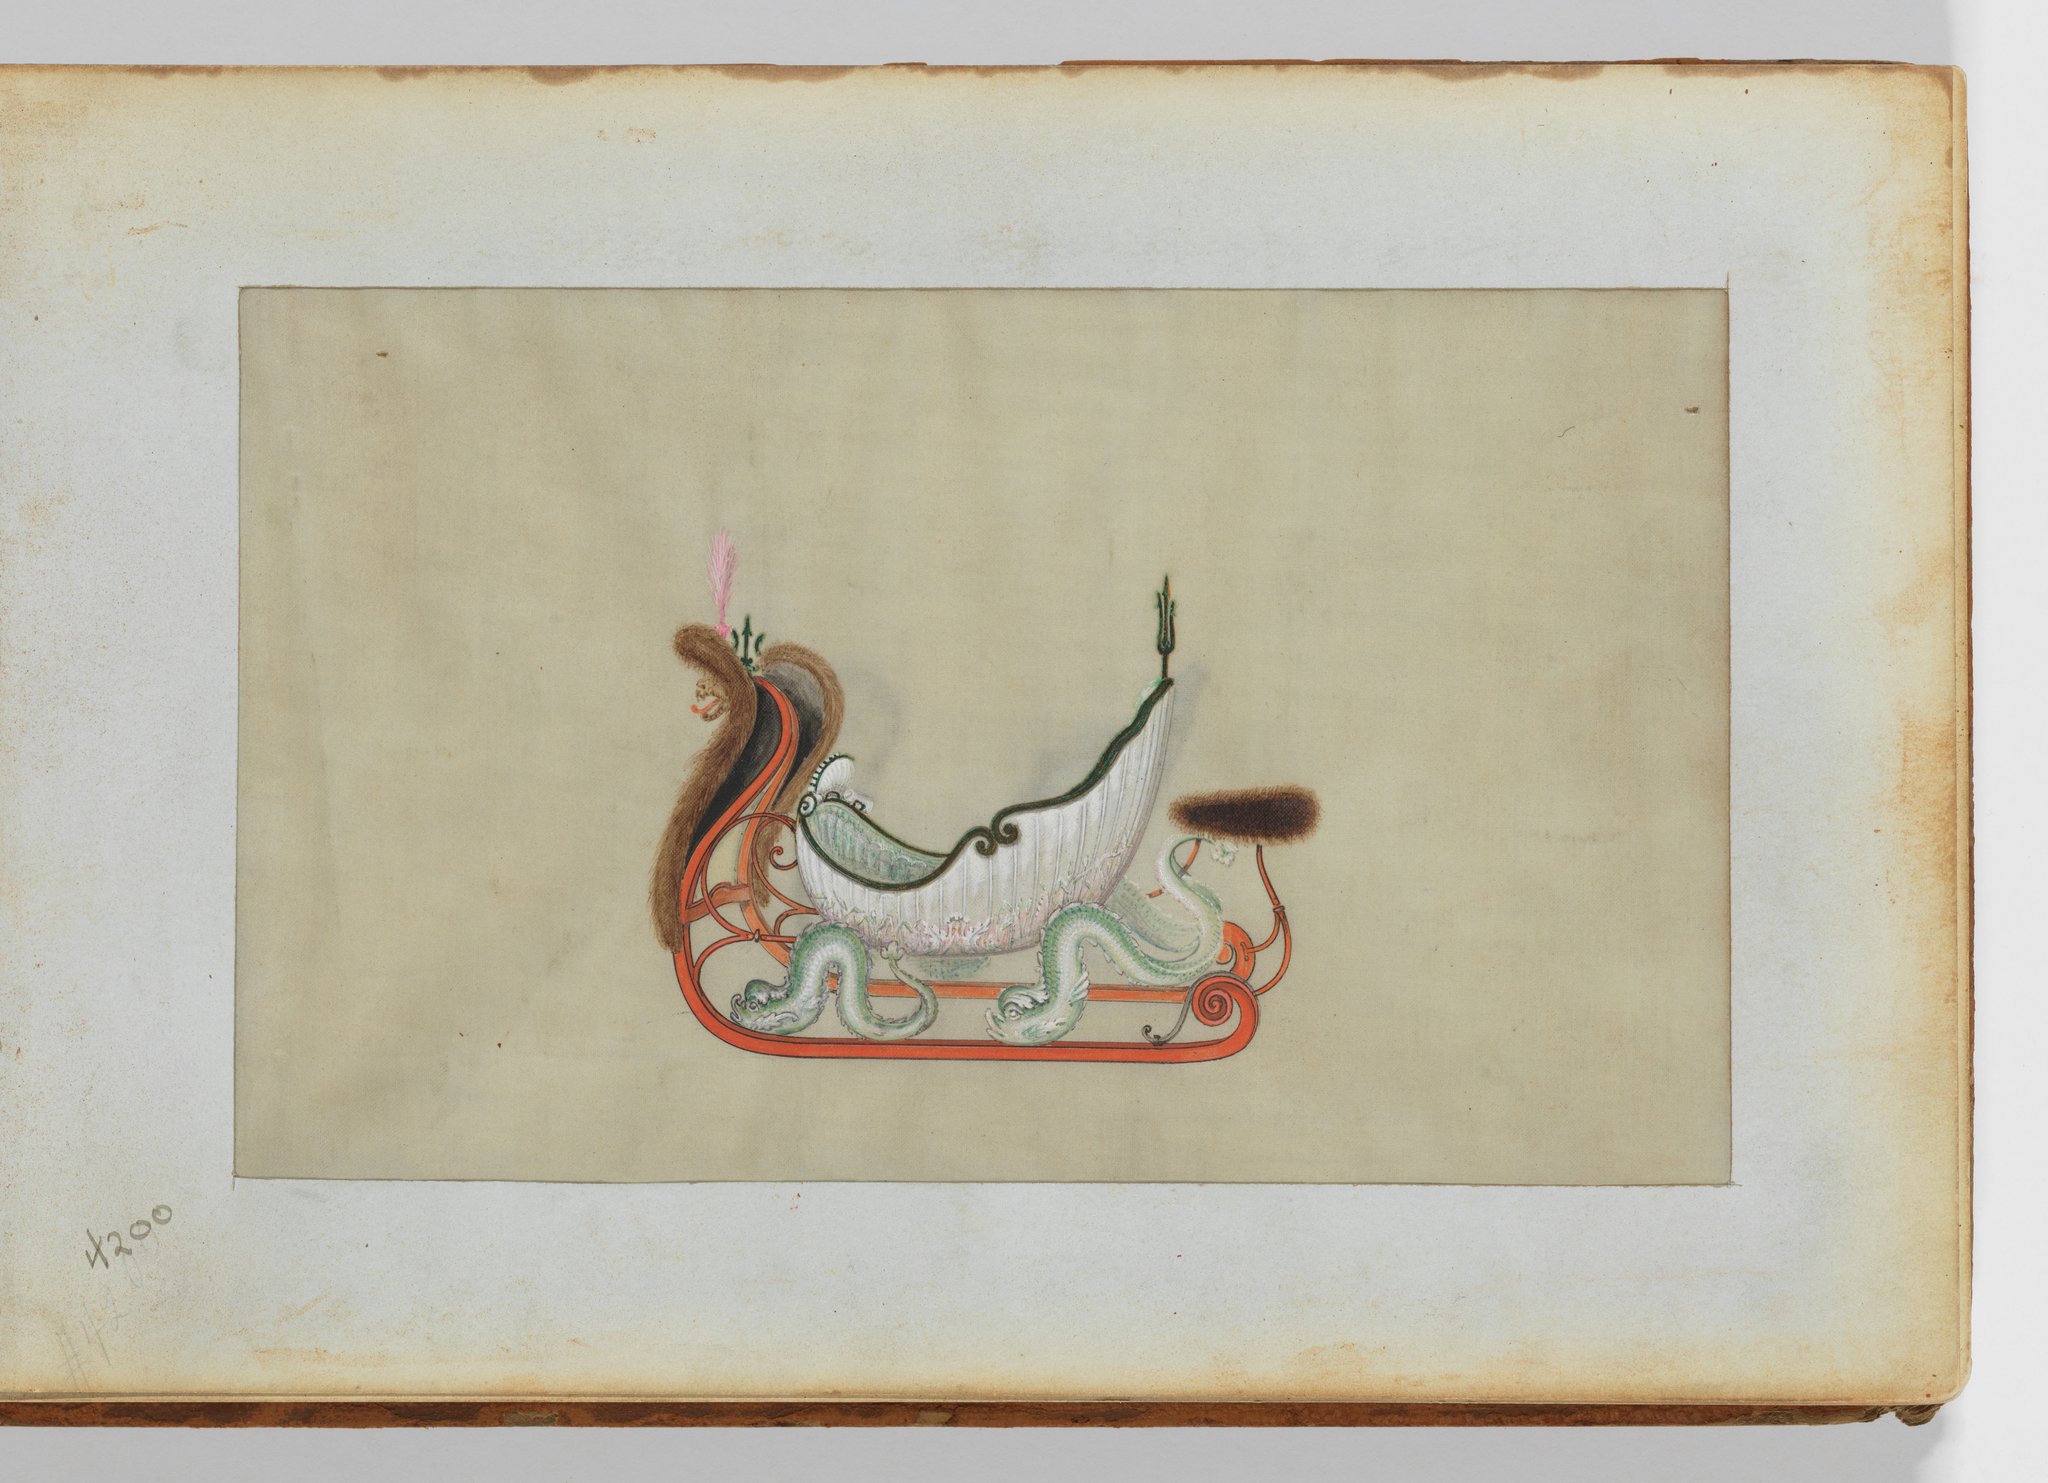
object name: album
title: Sleighs, Series 1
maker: brewster & co.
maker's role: manufacturer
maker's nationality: american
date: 1882-1893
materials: gouache, ink, watercolor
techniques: bookbinding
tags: sleighs